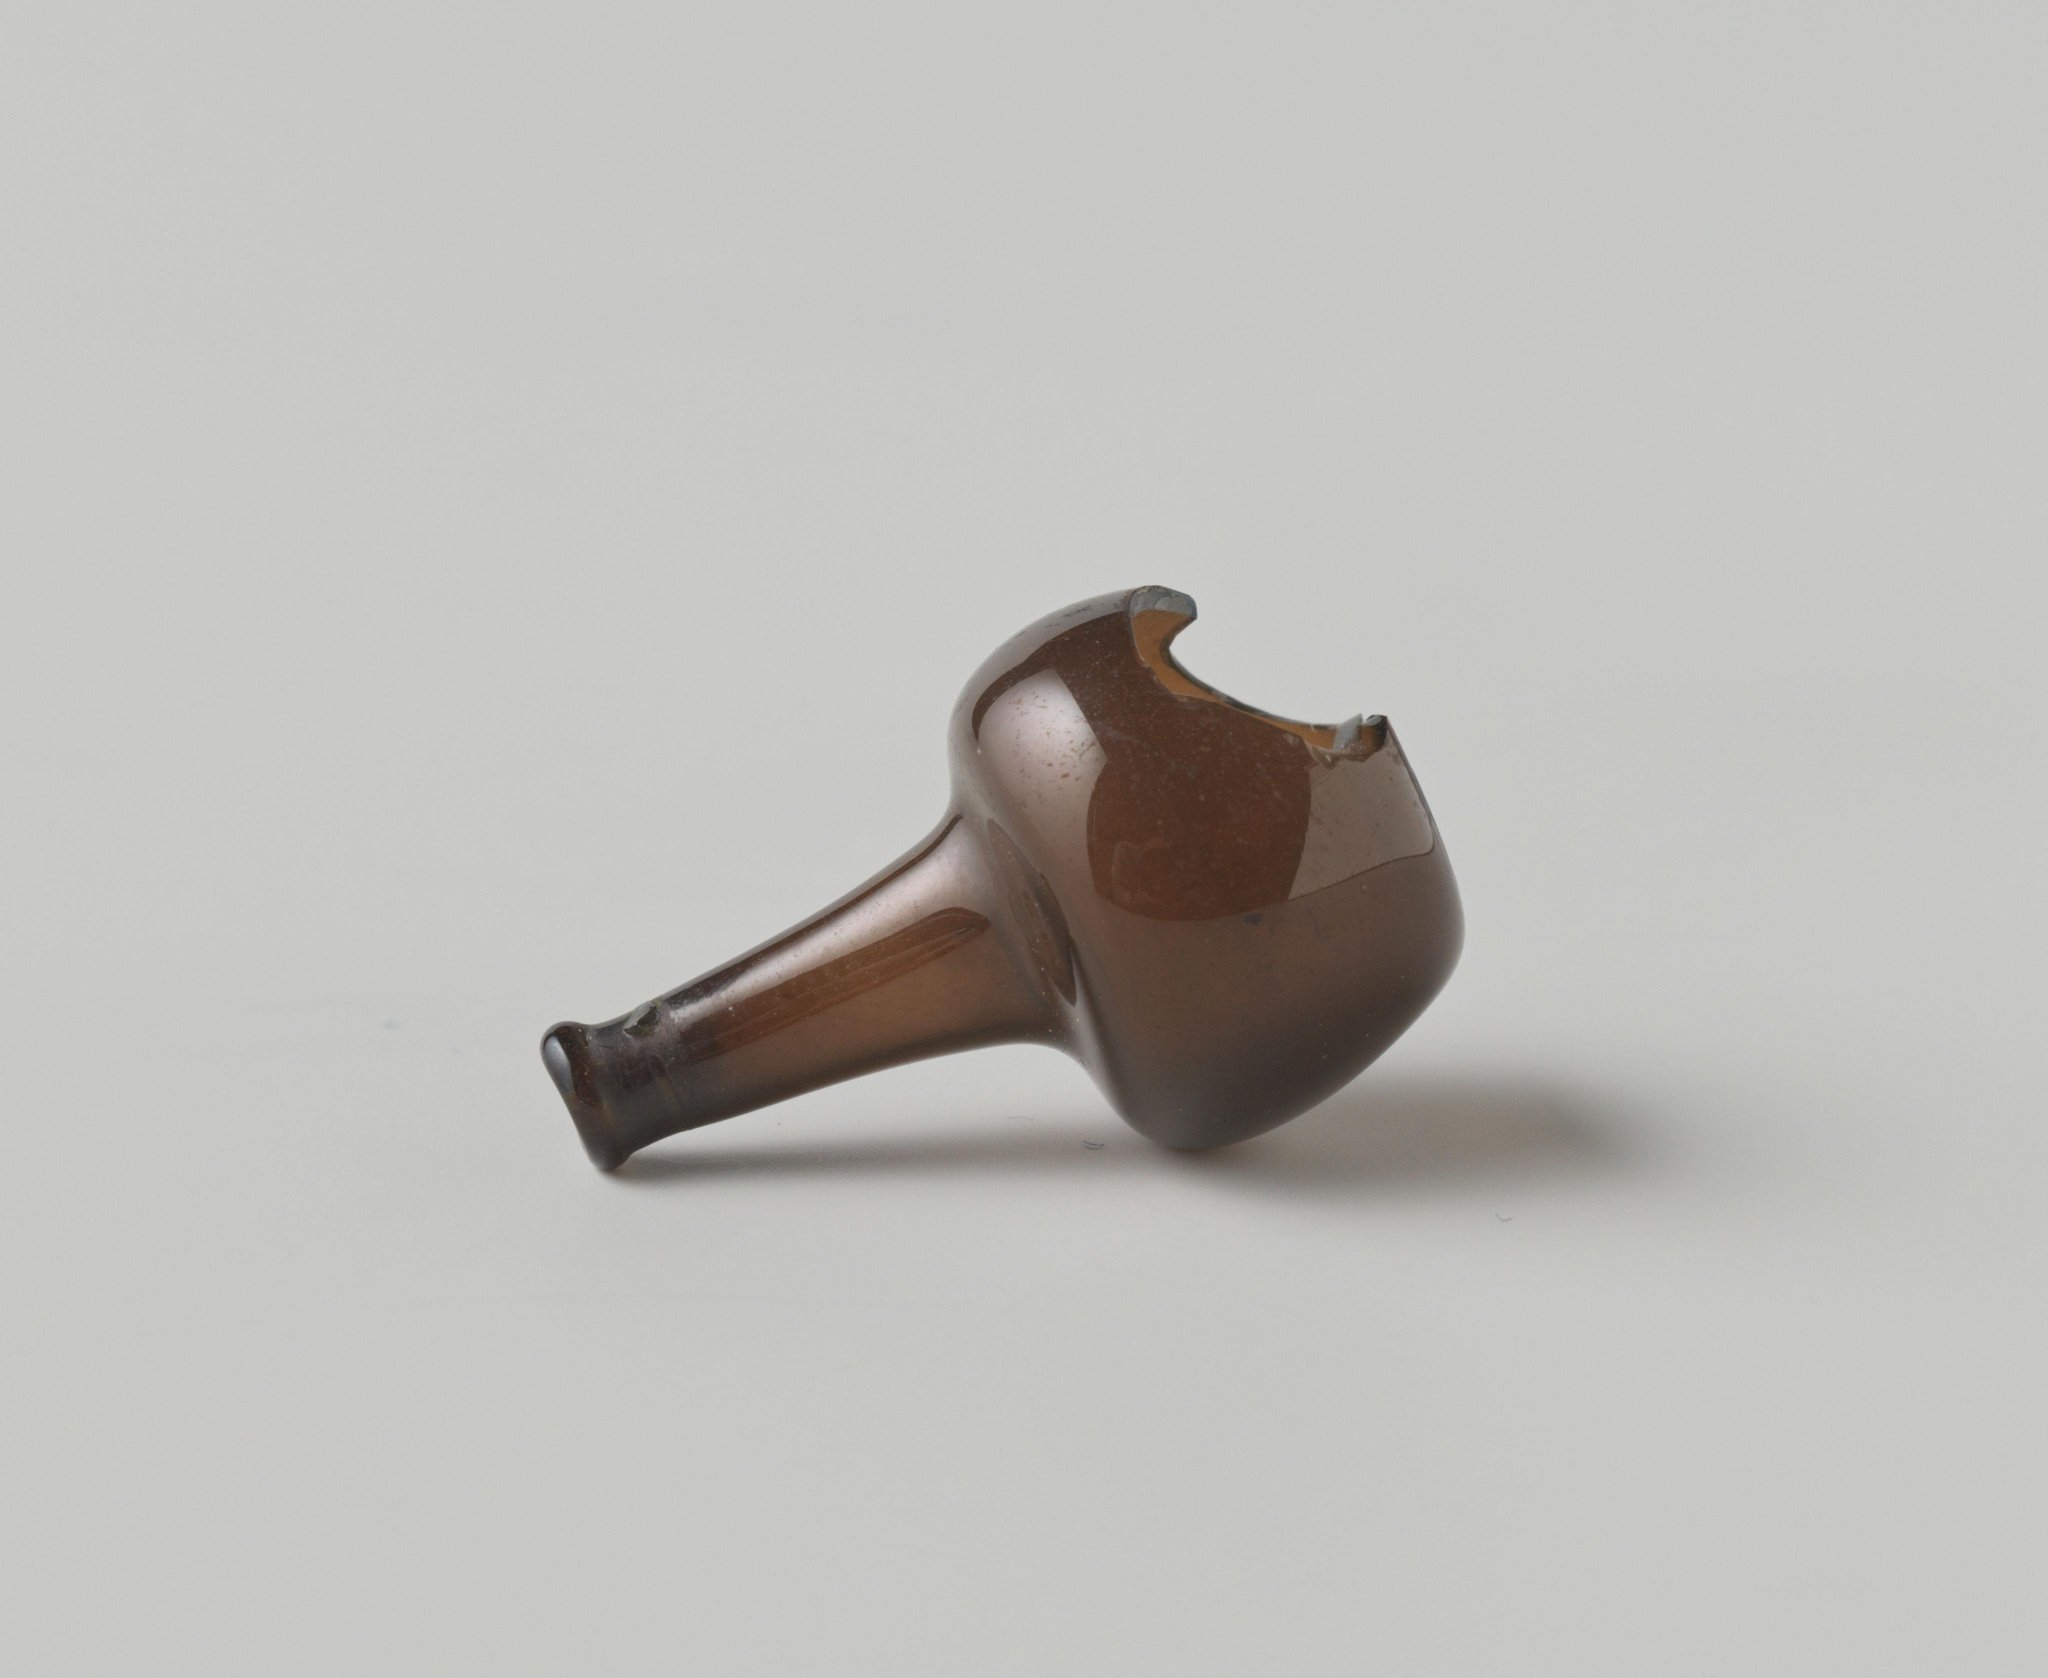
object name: miniature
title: Fles van helder azuurblauw glas; buik met ingestoken ziel, hoge hals met druipring (grotendeels afgebroken), in de halsopening een kurk.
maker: Anonymous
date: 1675-1710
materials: cork, glass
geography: amsterdam